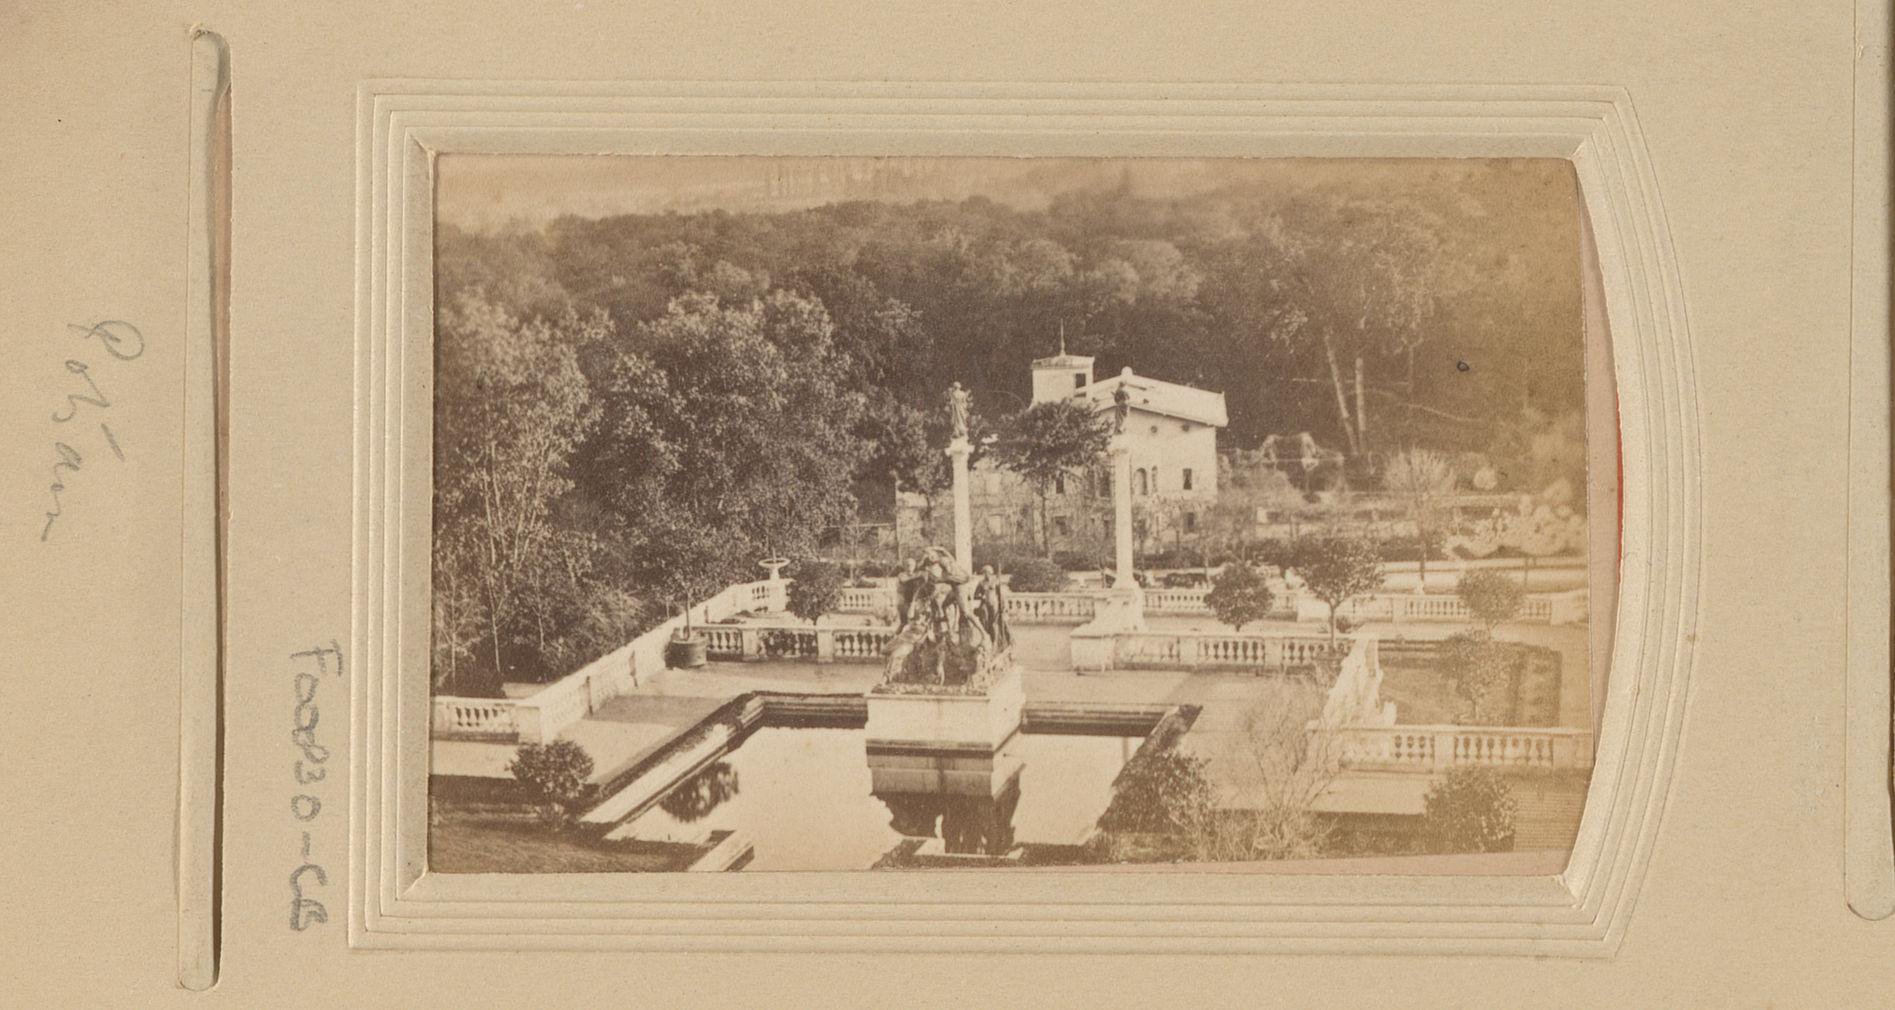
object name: album leaf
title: Gezicht op de tuinen bij het Orangeriepaleis te Potsdam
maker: adolphe block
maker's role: publisher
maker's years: 1829-1918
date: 1870-1900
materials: cardboard, photographic support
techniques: albumen print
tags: trees, terrace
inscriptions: inscription: ‘BK’